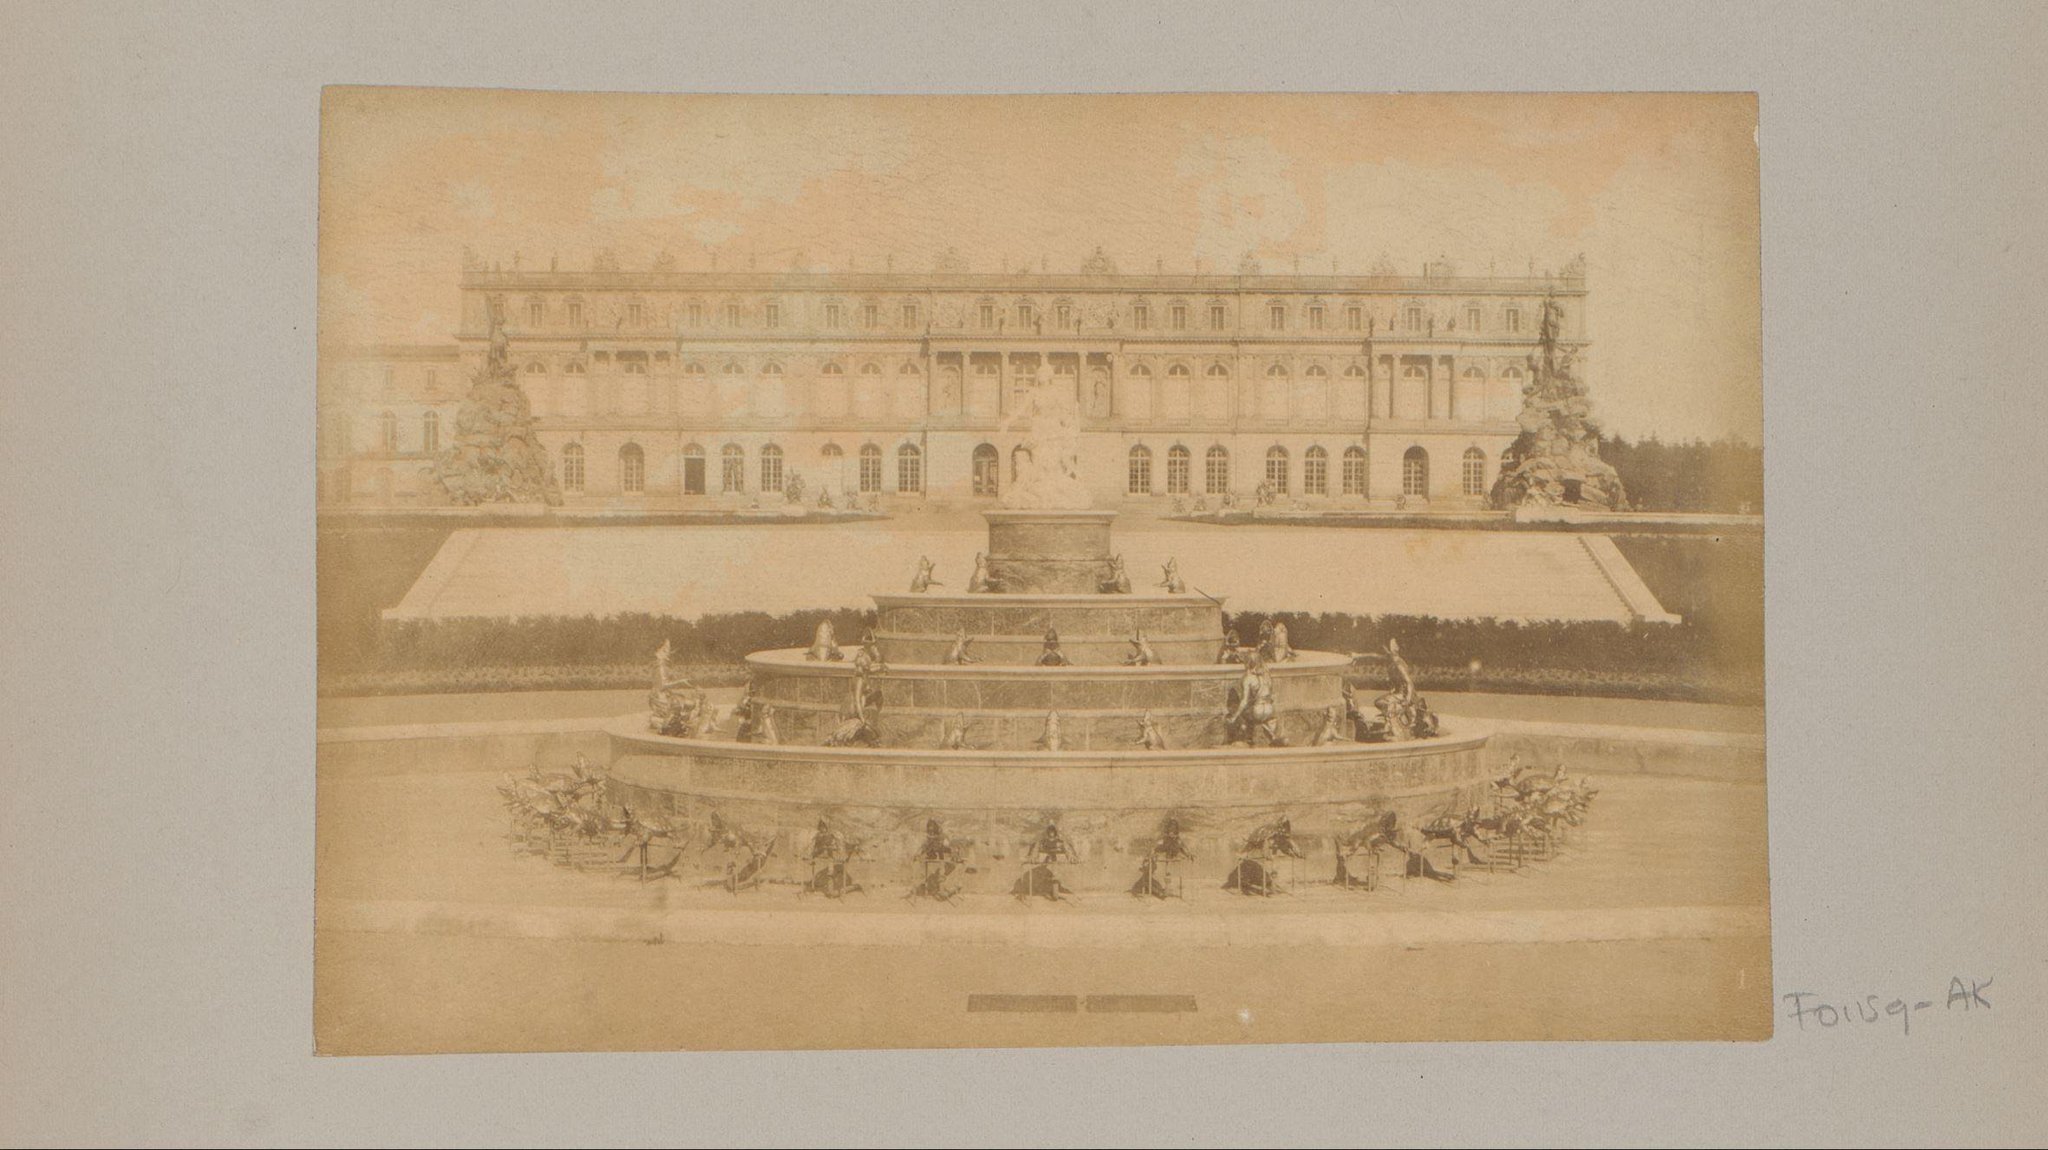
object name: photograph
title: Gezicht op Slot Herrenchiemsee met een fontein, de Latonabrunnen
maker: Anonymous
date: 1880-1900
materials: photographic support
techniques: albumen print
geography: herrenchiemsee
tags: garden fountain, palace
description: Onderdeel van Reisalbum met opnames van bezienswaardigheden in Zweden, Noorwegen, Denemarken, Beieren, Milaan en Parijs.